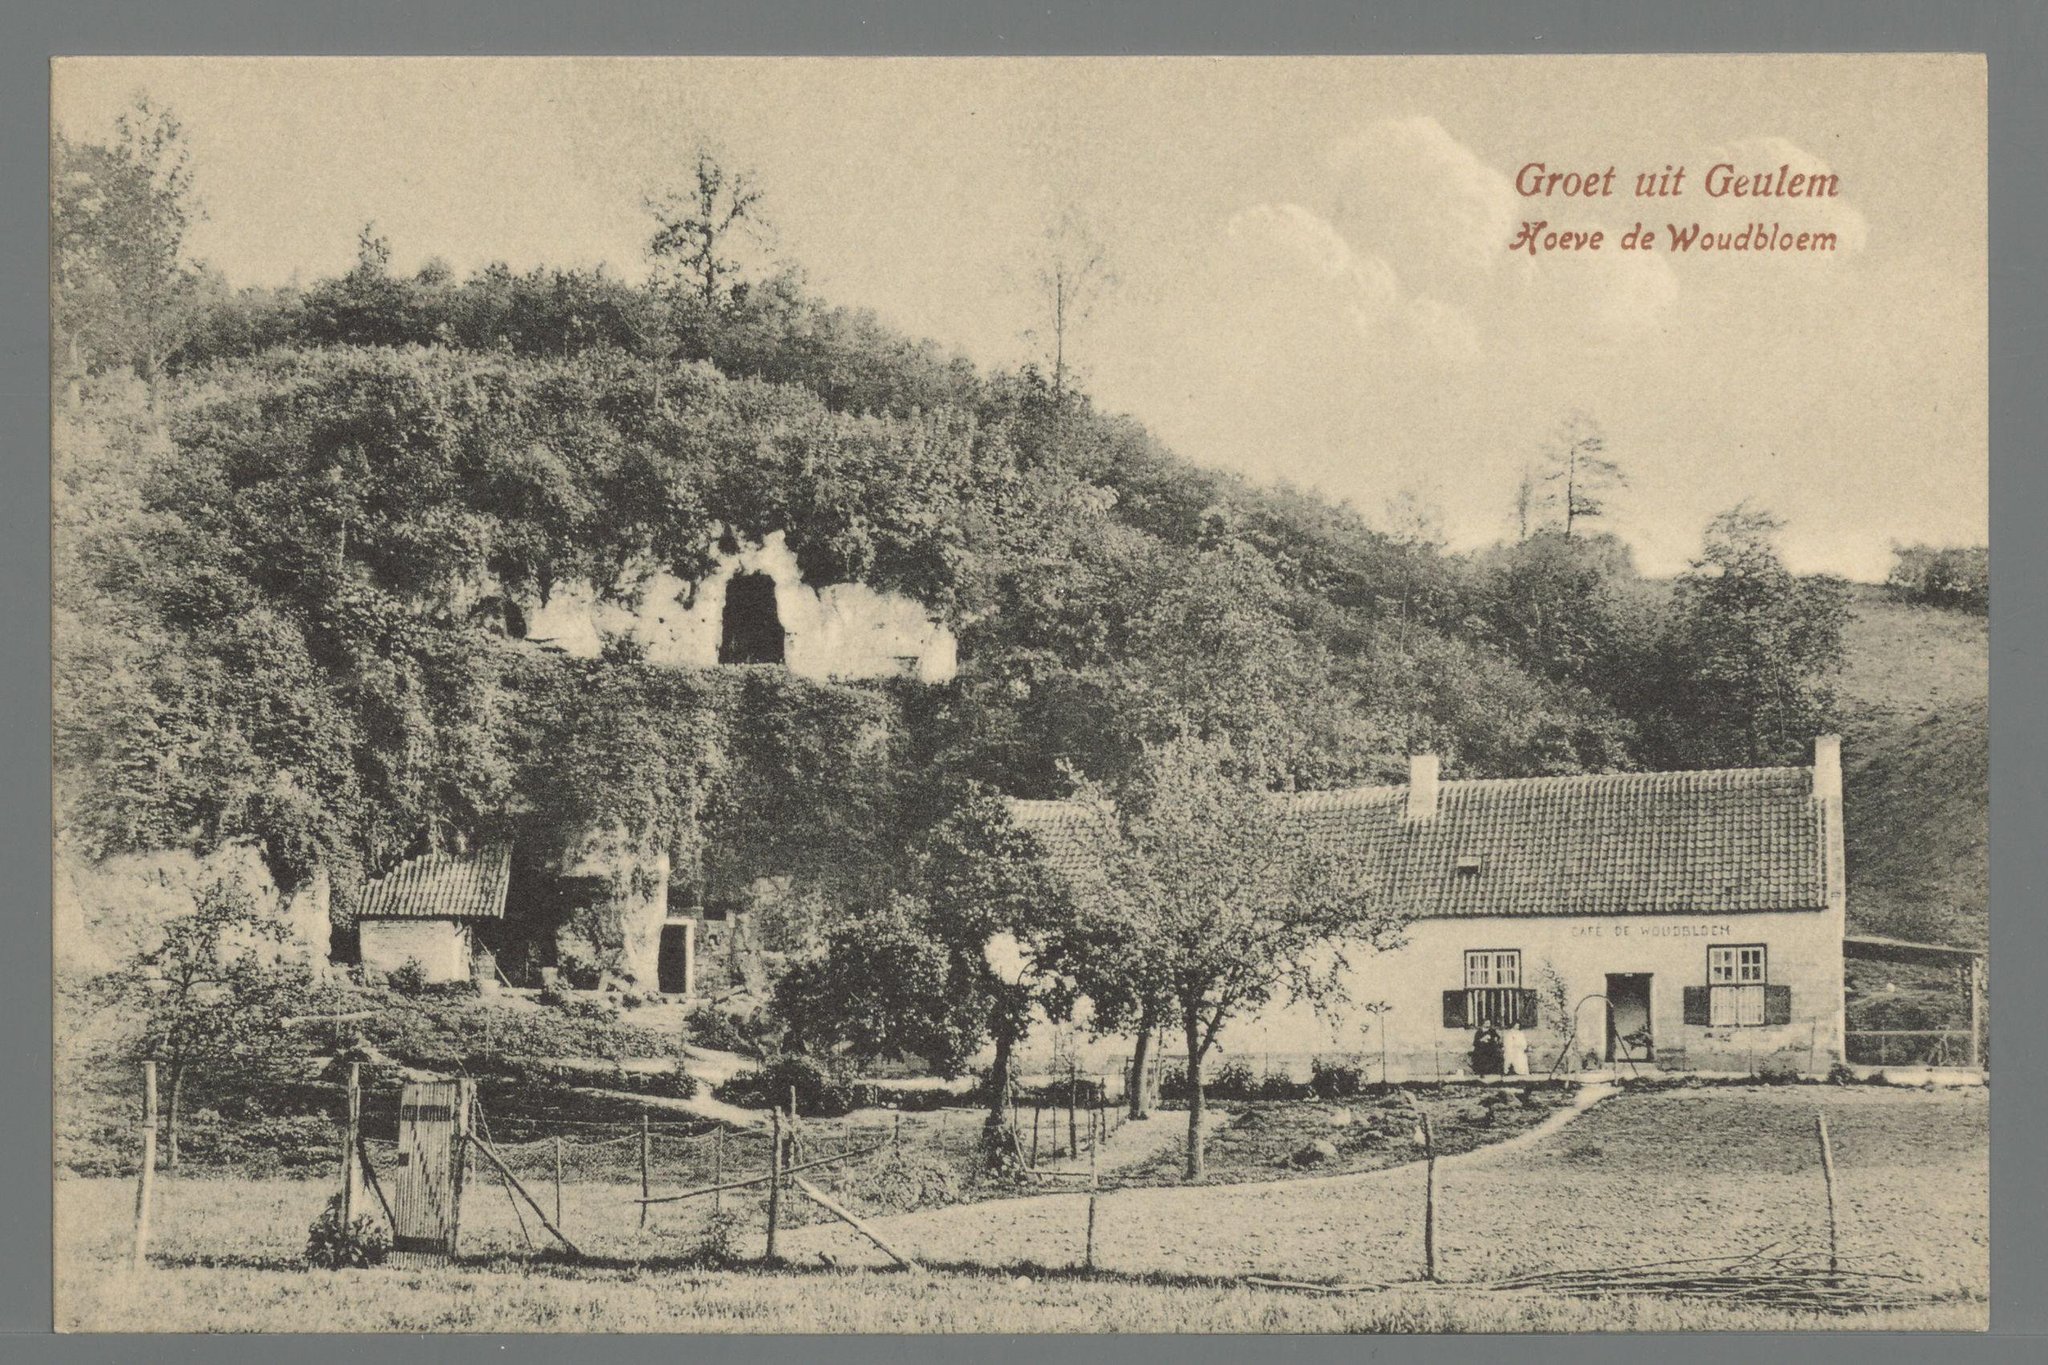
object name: ansichtkaart, prentbriefkaart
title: Groet uit Geulem. Hoeve de Woudbloem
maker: Anonymous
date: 1905-1930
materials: cardboard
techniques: photograph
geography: geulhem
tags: inn, coffee-house, public house, etc., cave, grotto